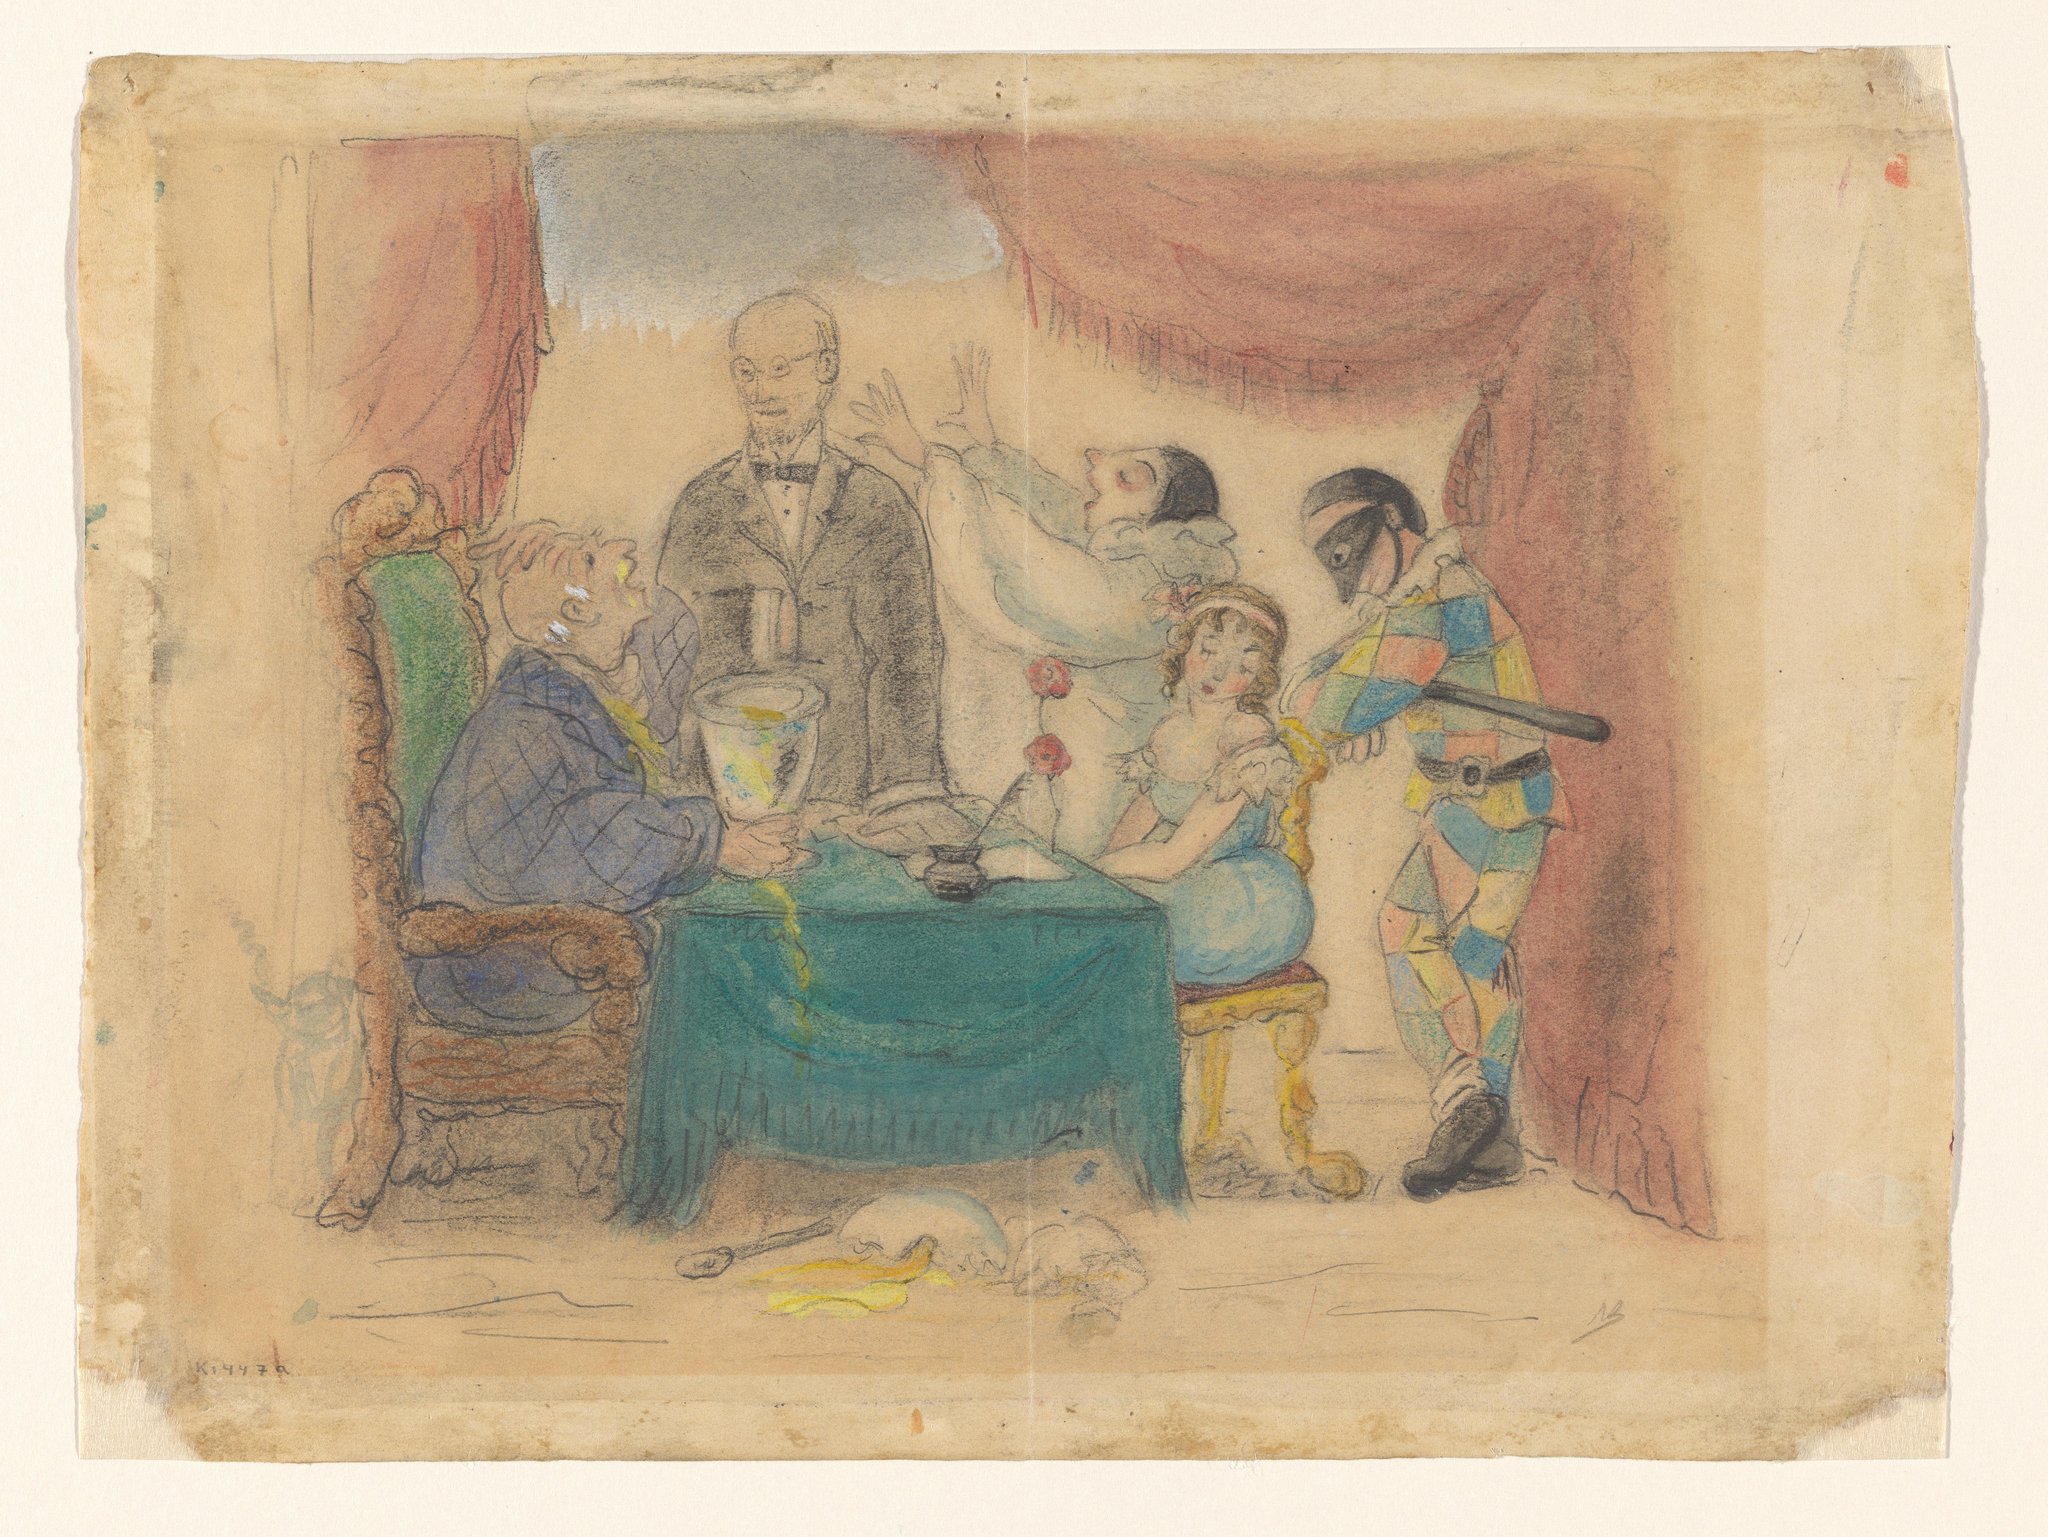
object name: drawing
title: De huwelijksdag van Pierrot en Colombine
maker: nelly bodenheim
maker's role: designer, draughtsman, print maker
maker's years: 1874-1951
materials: paint, ink, paper, pencil, watercolor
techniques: brush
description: Oom Cassander grijpt naar zijn kale hoofd nadat Vogel Rok, van wie hij een enorm ei had gestolen als feestmaal bij het huwelijk van Pierrot en zijn dochter Colombine, zijn pruik stal.